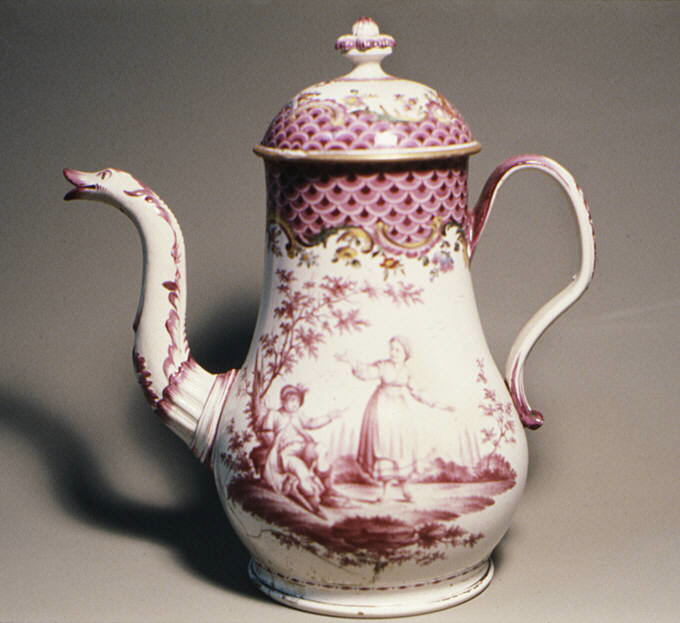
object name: coffeepot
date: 1760-1765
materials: enamel, stoneware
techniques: polychrome, salt glaze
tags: women,trees